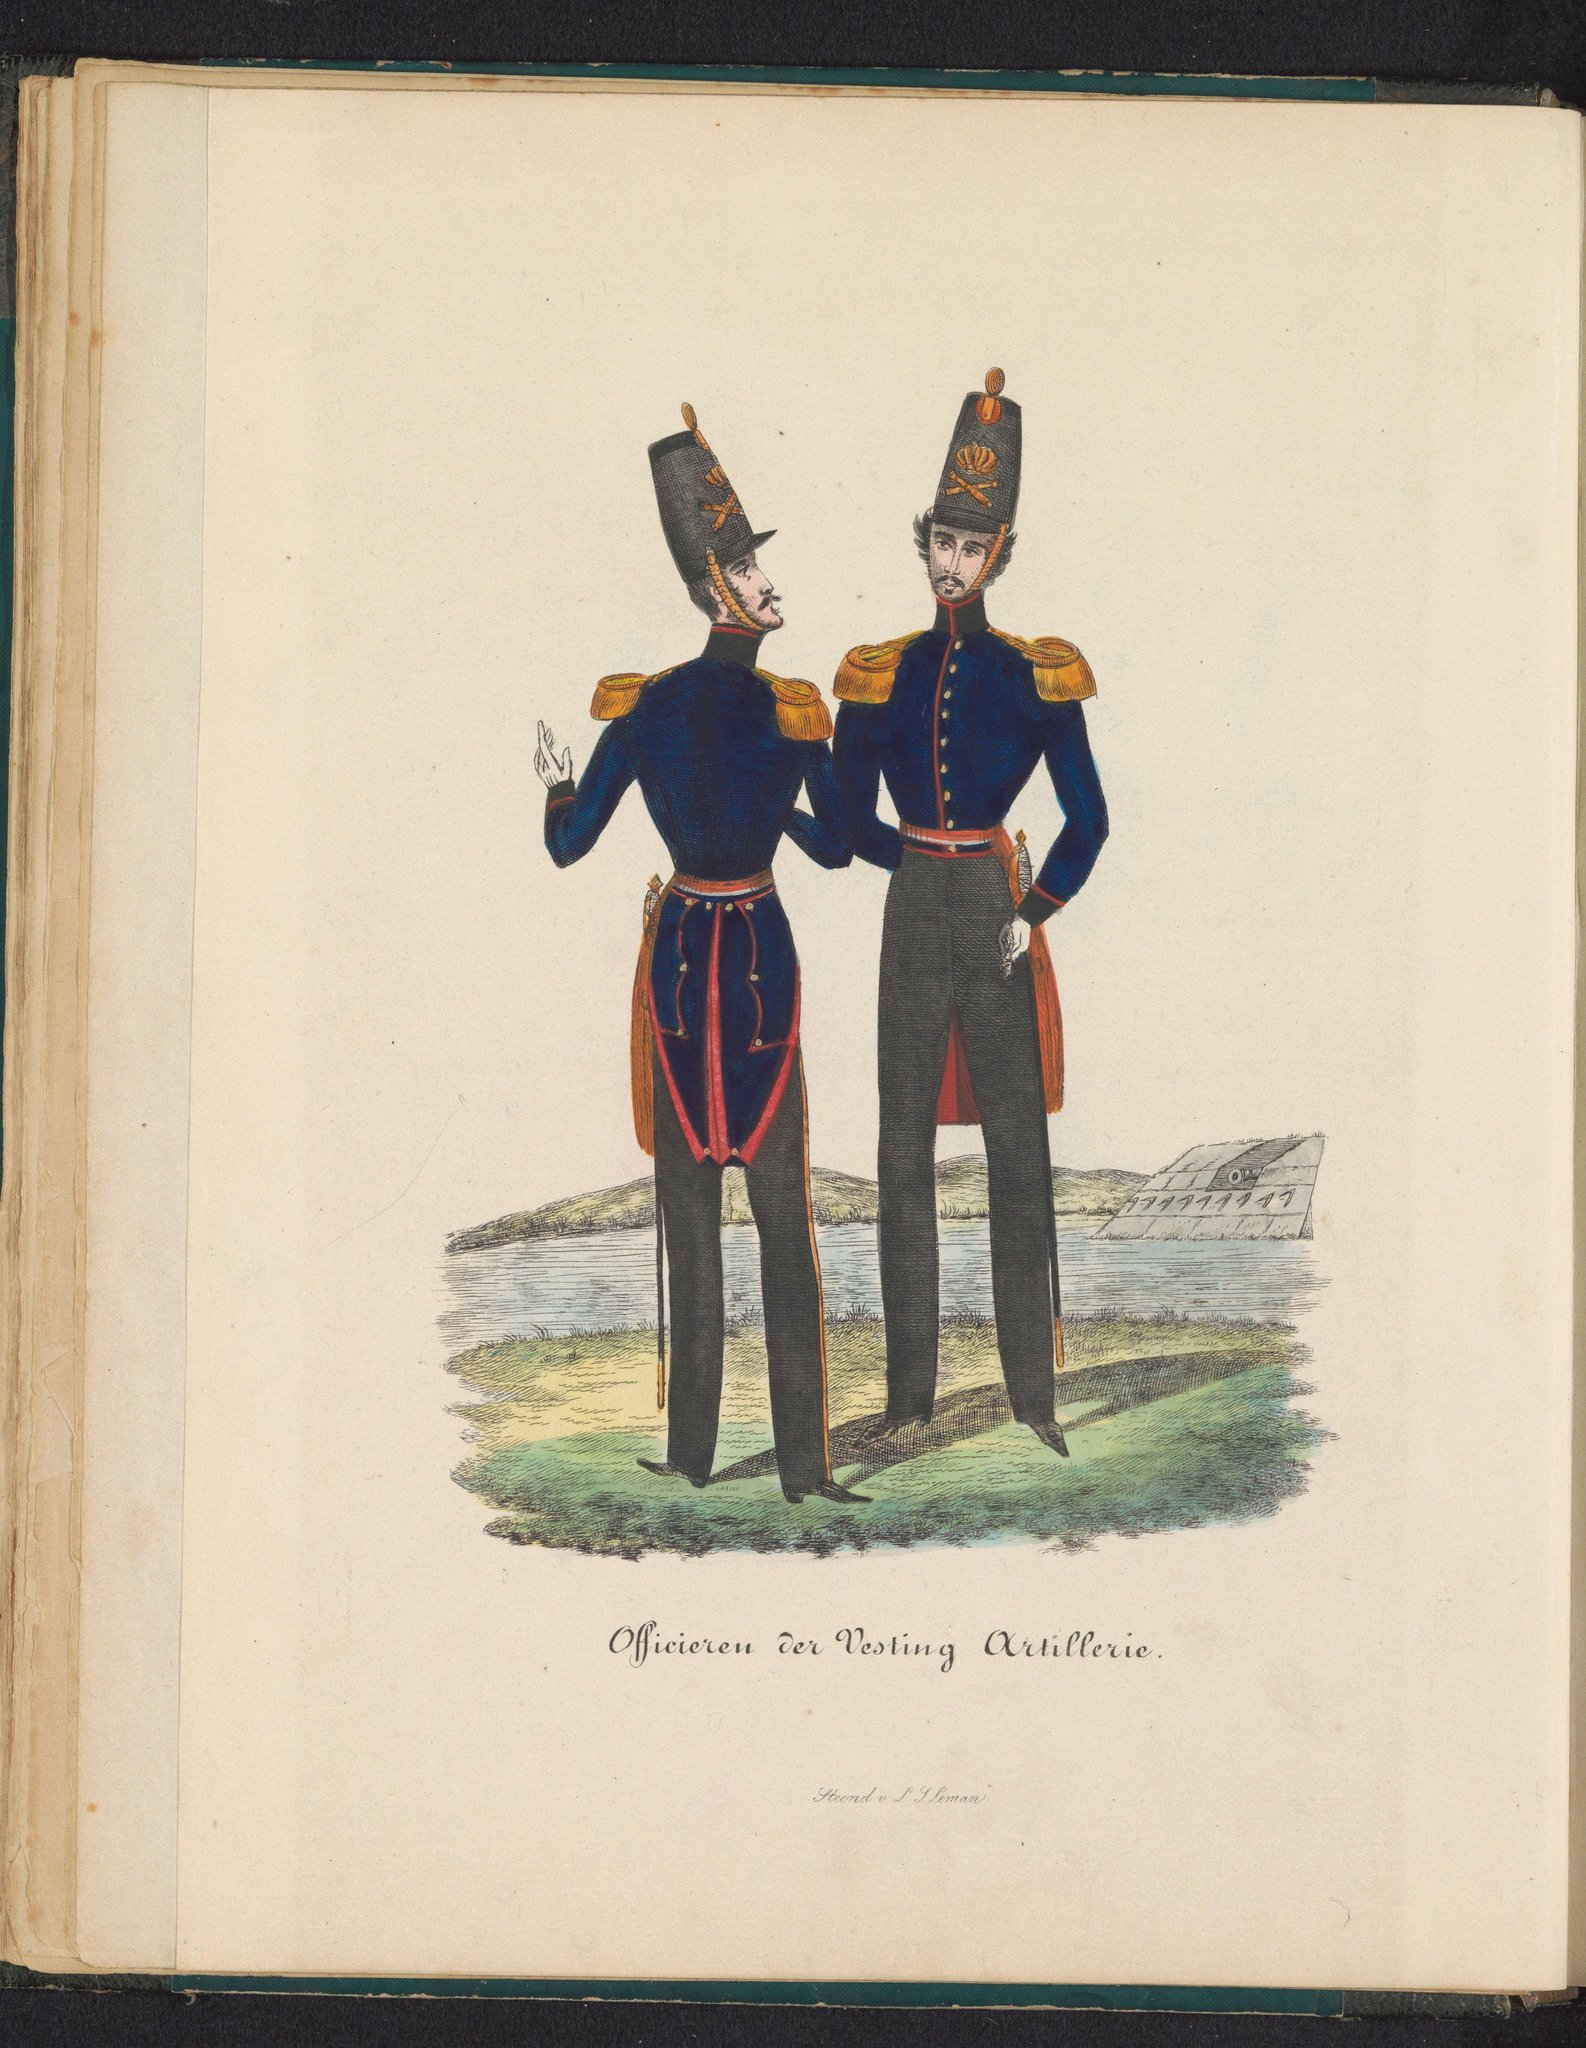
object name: costume print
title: Uniform van de officieren van de vestingartillerie, 1845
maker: louis salomon leman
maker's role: steendrukker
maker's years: 1818-1889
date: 1845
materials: paper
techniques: hand coloring, lithograph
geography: amsterdam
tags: (military) uniforms, netherlands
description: Uniform van de officieren van de vestingartillerie. Illustratie in een boek uit 1845 over de uniformen en kledingstukken van de Nederlandse land-, zeemacht en schutterijen in Nederland en in de overzeese gebiedsdelen.